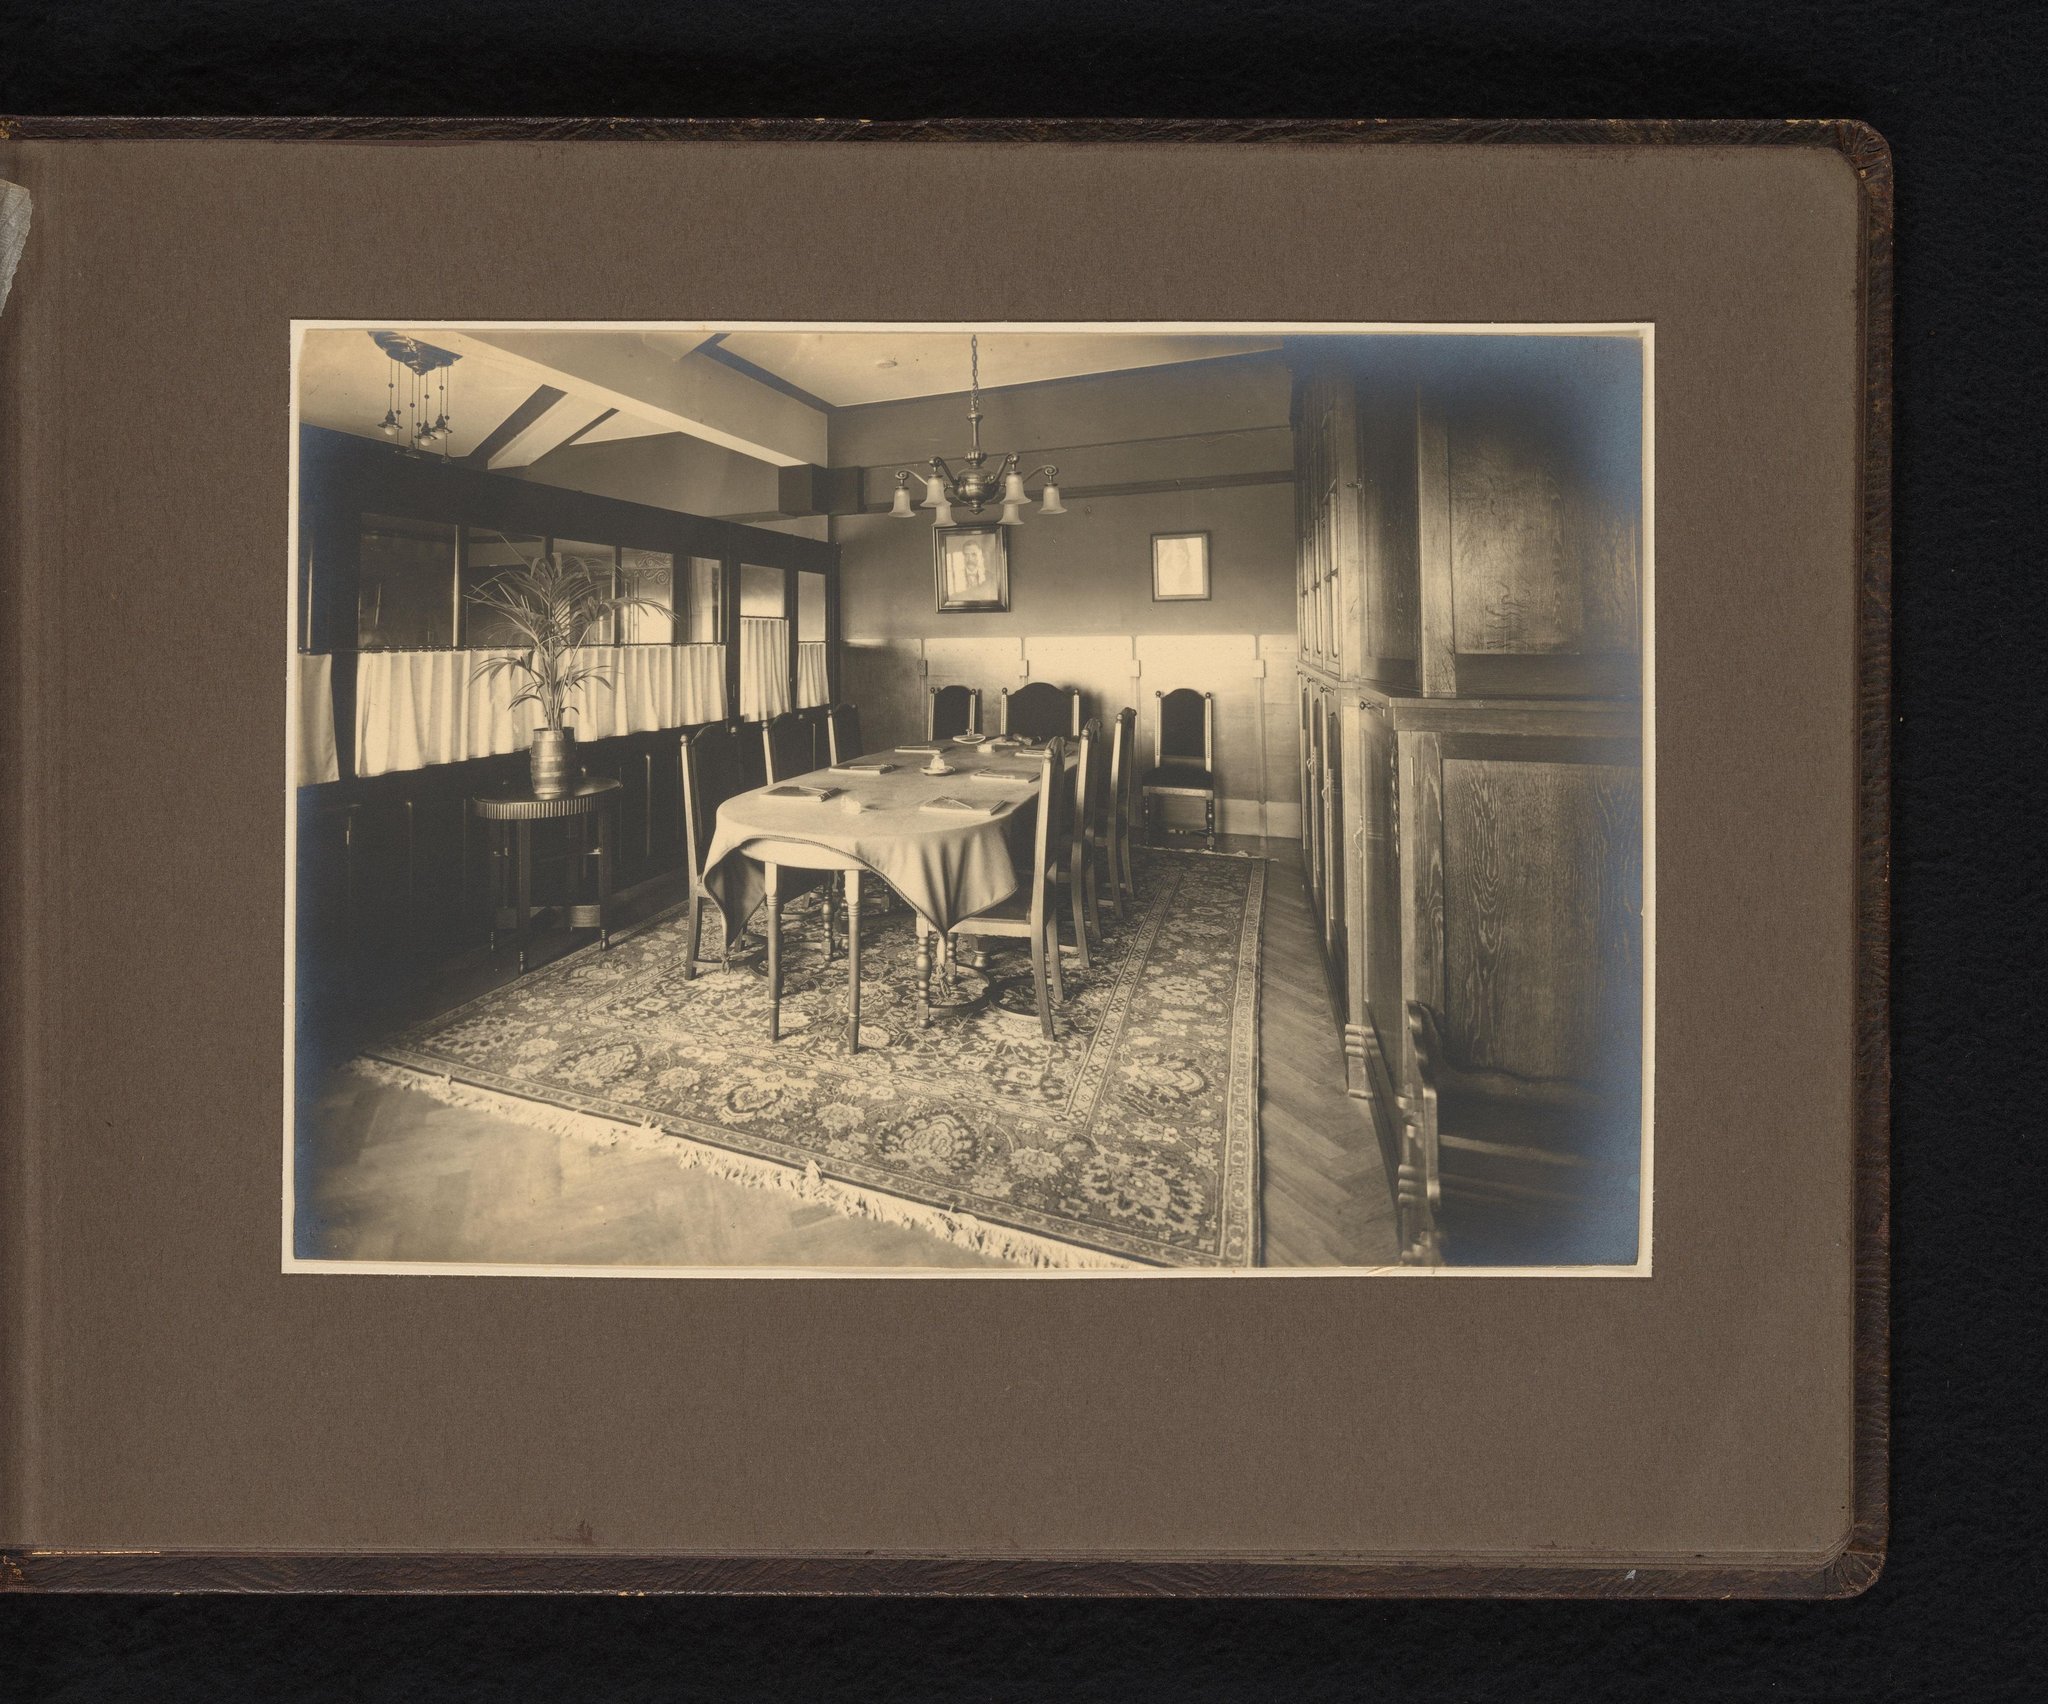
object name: album leaf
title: Gezicht op een vergaderzaal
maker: Anonymous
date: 1900-1930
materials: cardboard, paper, photographic support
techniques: gelatin silver print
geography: amsterdam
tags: assembly-room, amsterdam